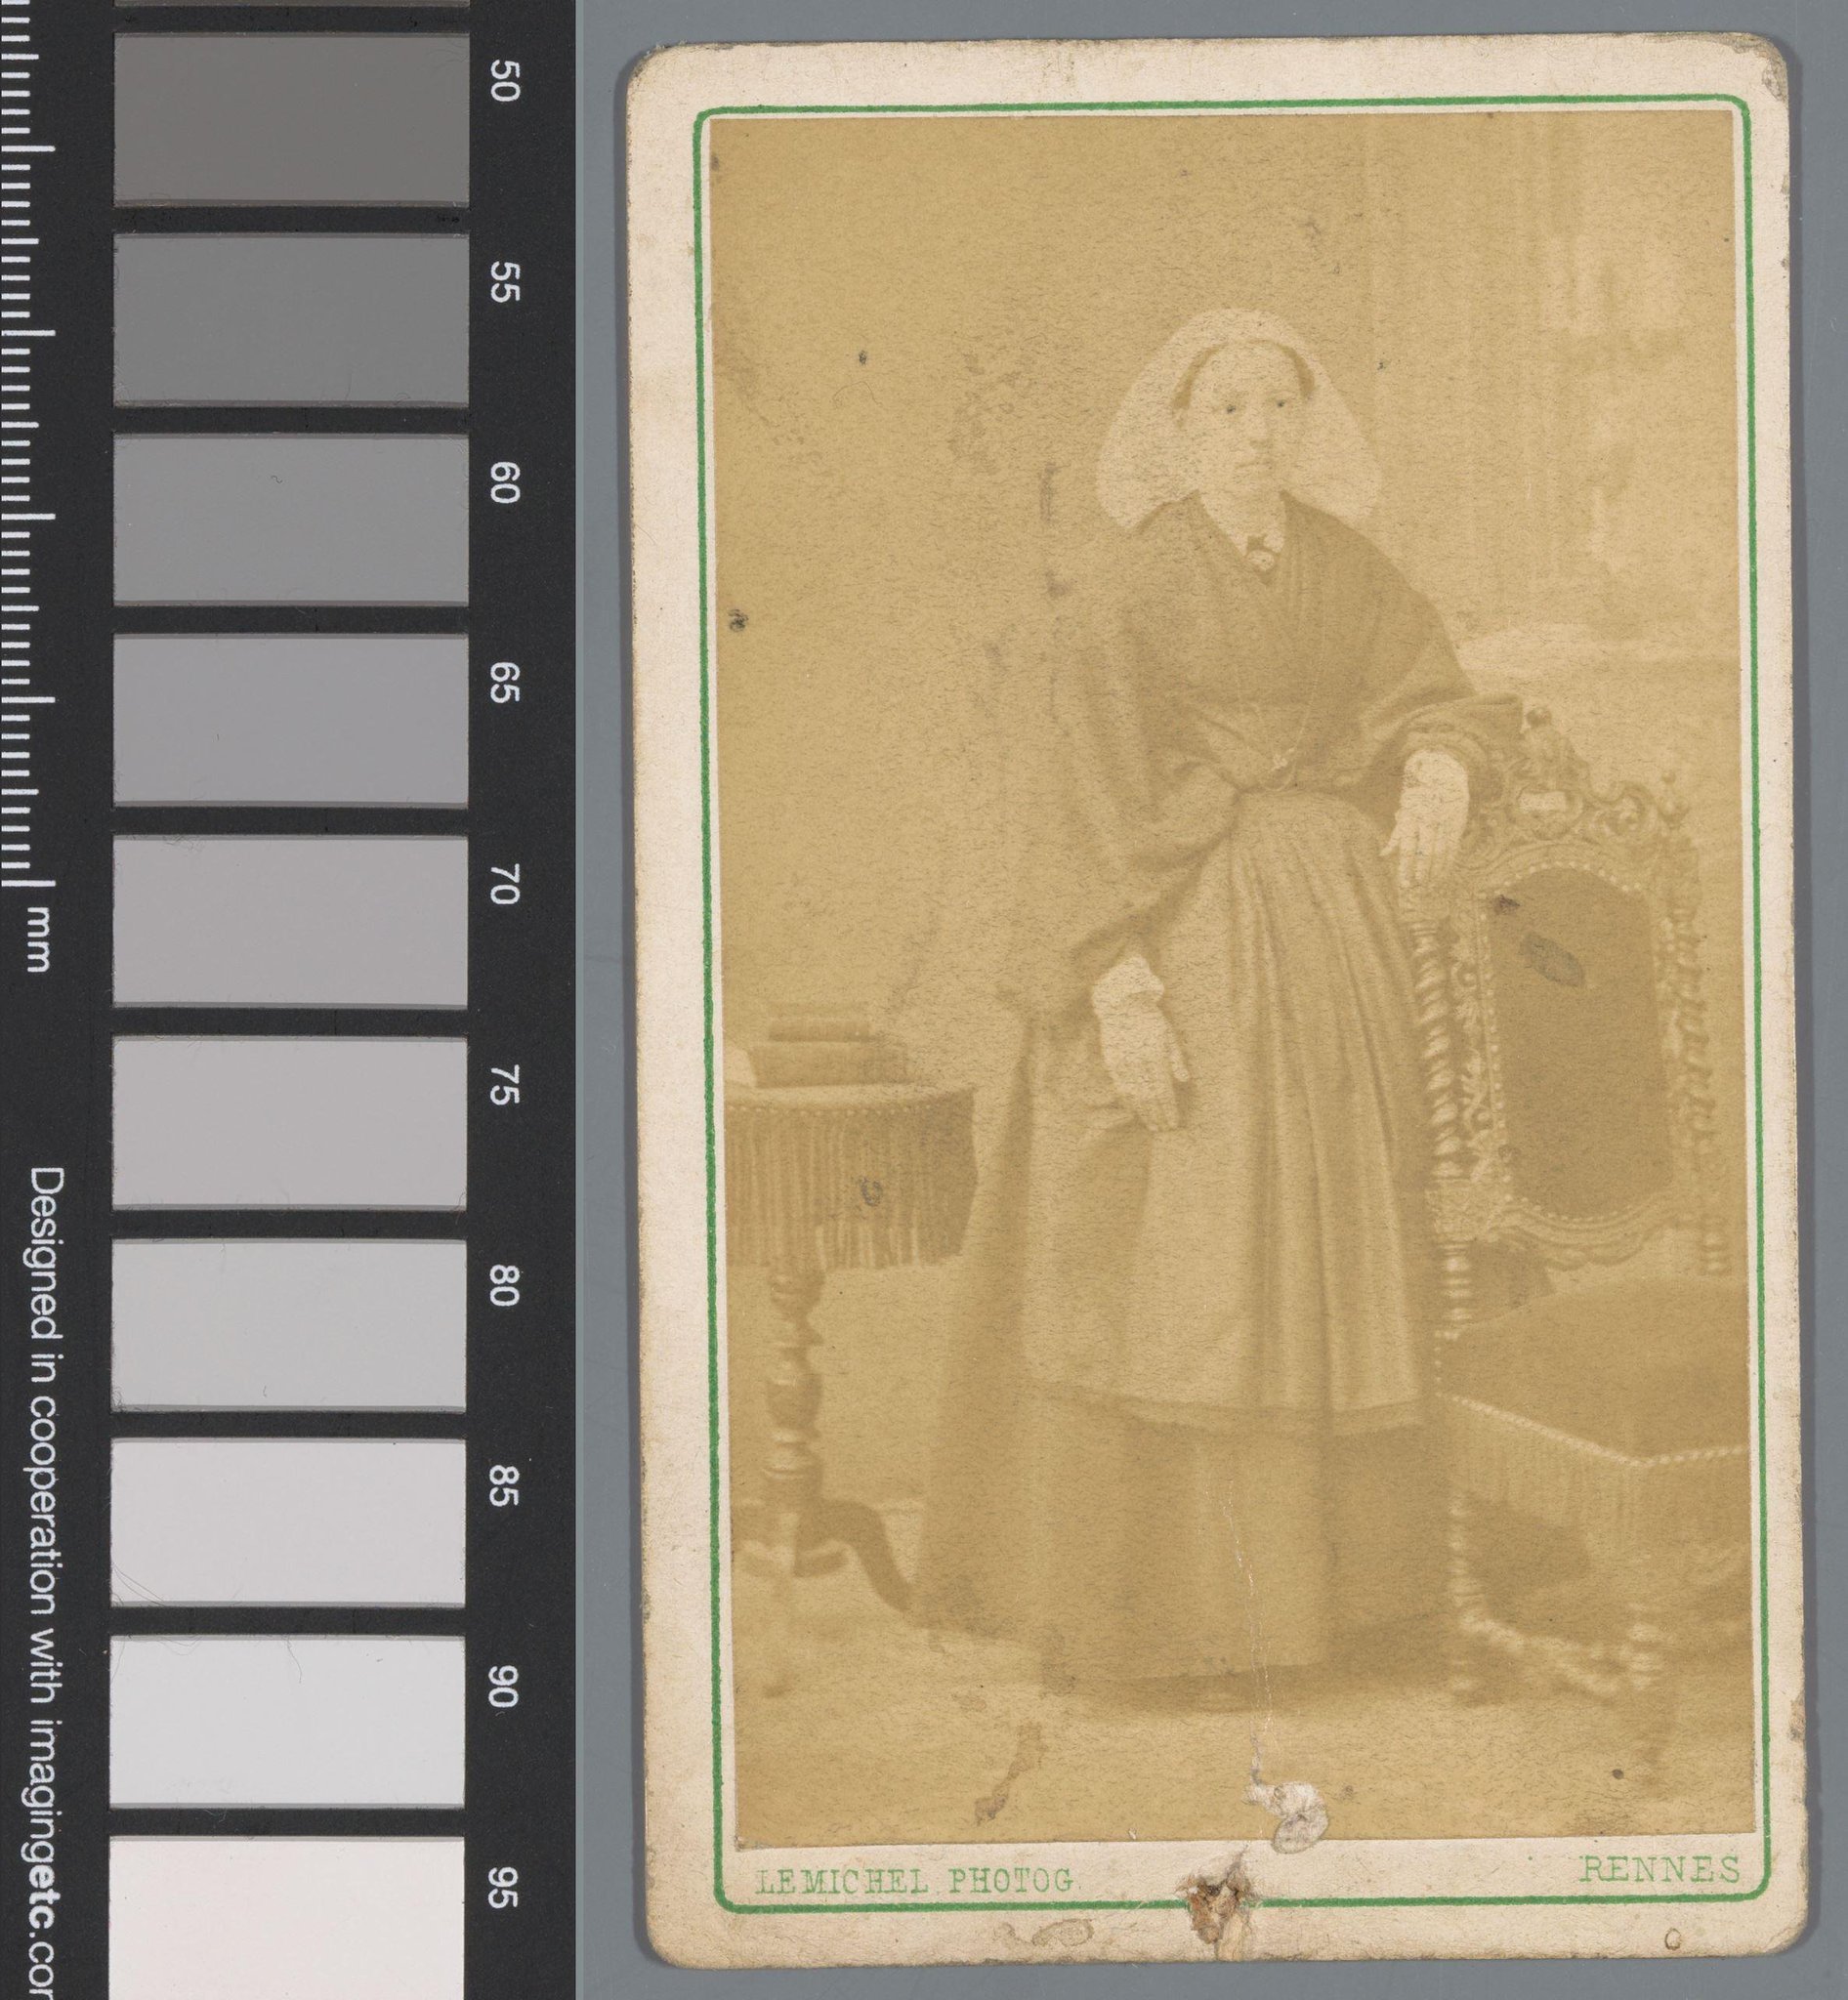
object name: carte de visite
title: Portret van een onbekende vrouw met hoofddeksel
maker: mathurin le michel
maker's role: fotograaf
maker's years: 1830-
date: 1875-1885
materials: cardboard, paper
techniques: albumen print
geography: rennes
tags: adult woman, head-gear: cap, anonymous historical person portrayed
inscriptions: address: ‘6bis Rue de Bel Air. 6bis/ RENNES.’, inscription: ‘Tous les Clichés étant conservés, on peut/ avoir de nouvelles épreuves sans reposer.’